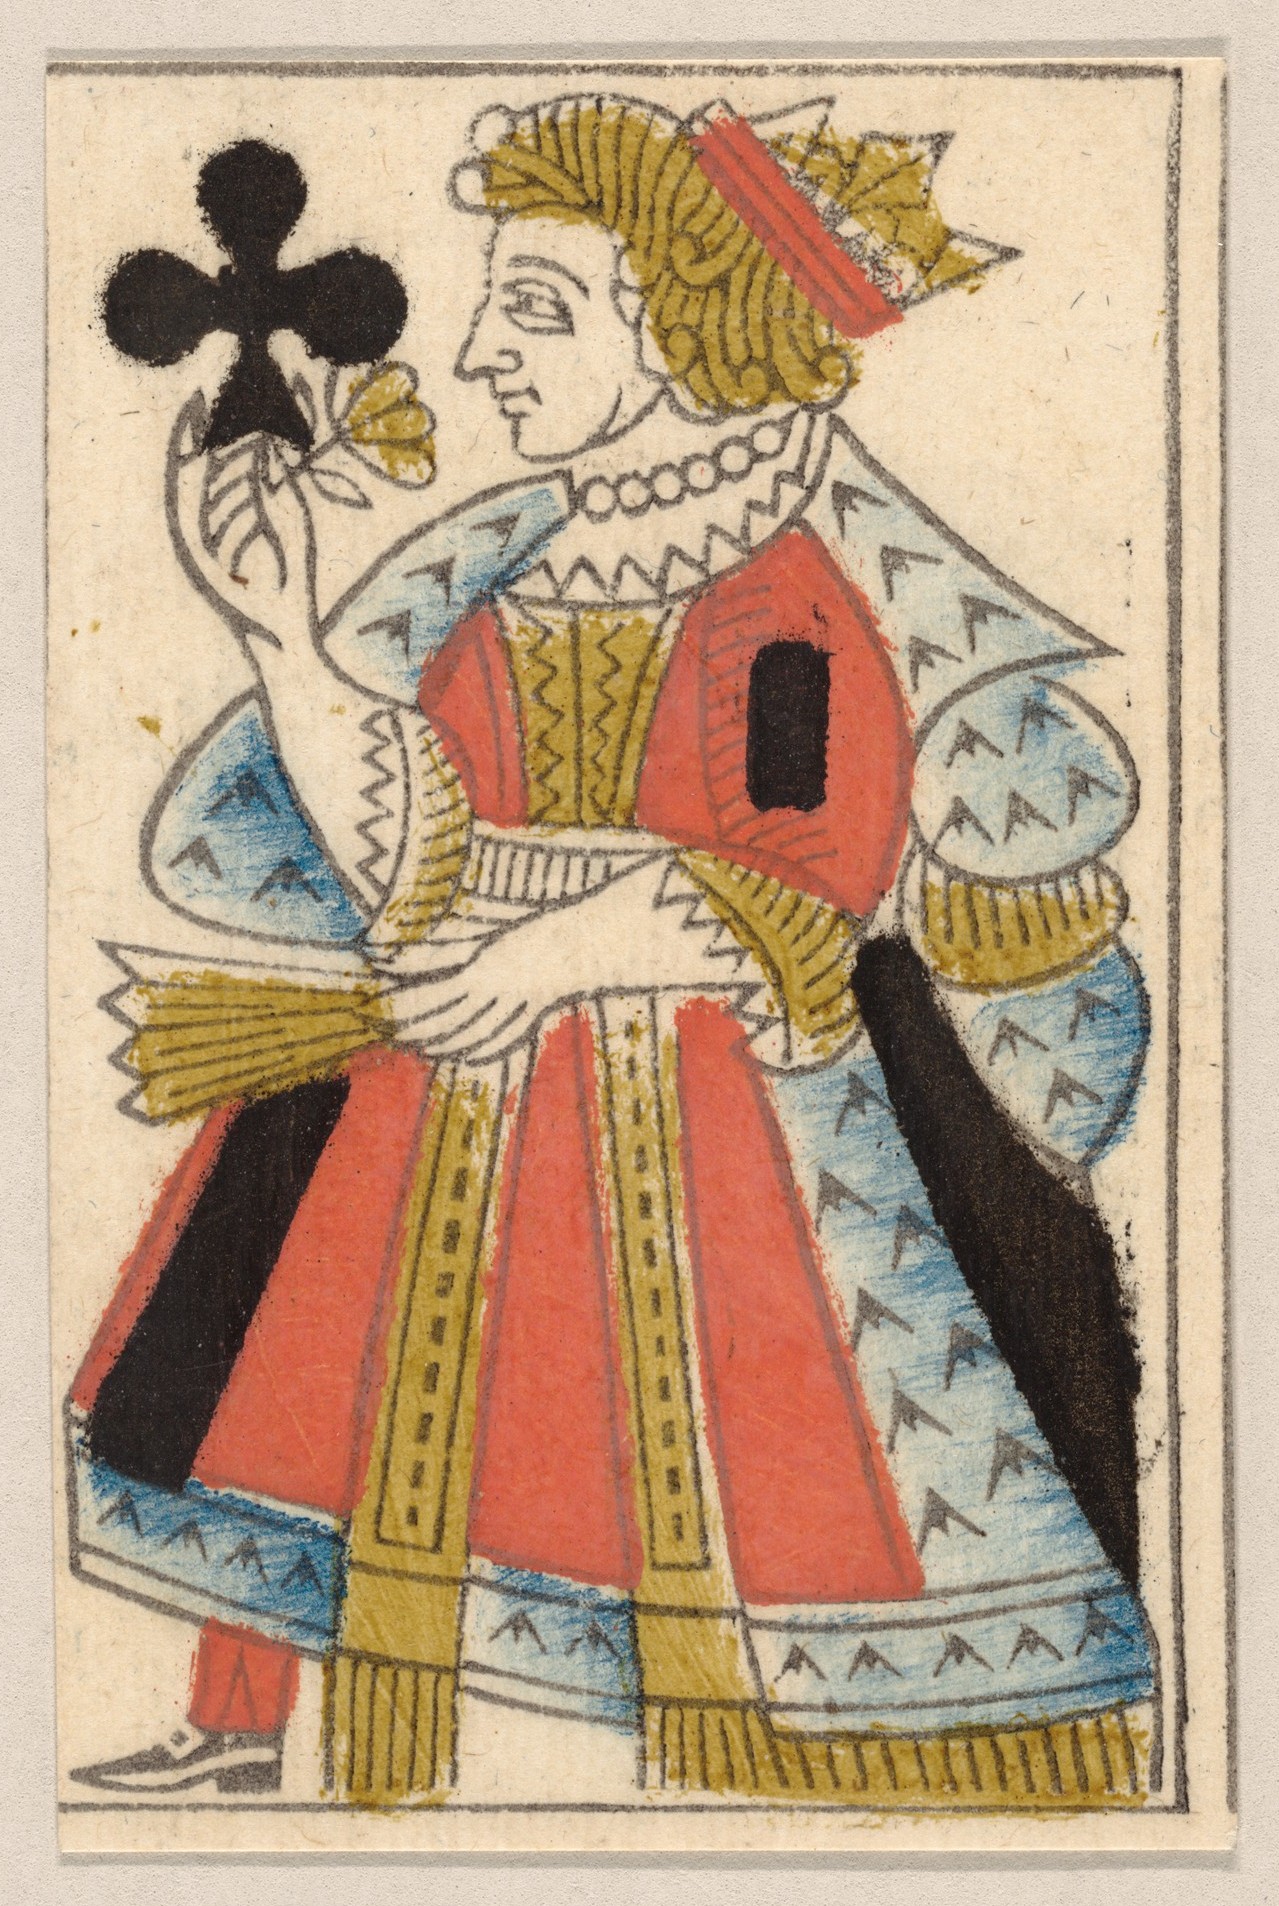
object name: print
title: Queen of Clubs, from a Set of Piquet Cards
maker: claude fayolle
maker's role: artist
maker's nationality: french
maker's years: 1752-1826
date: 1767-1900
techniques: hand coloring, woodcut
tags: queens,playing cards